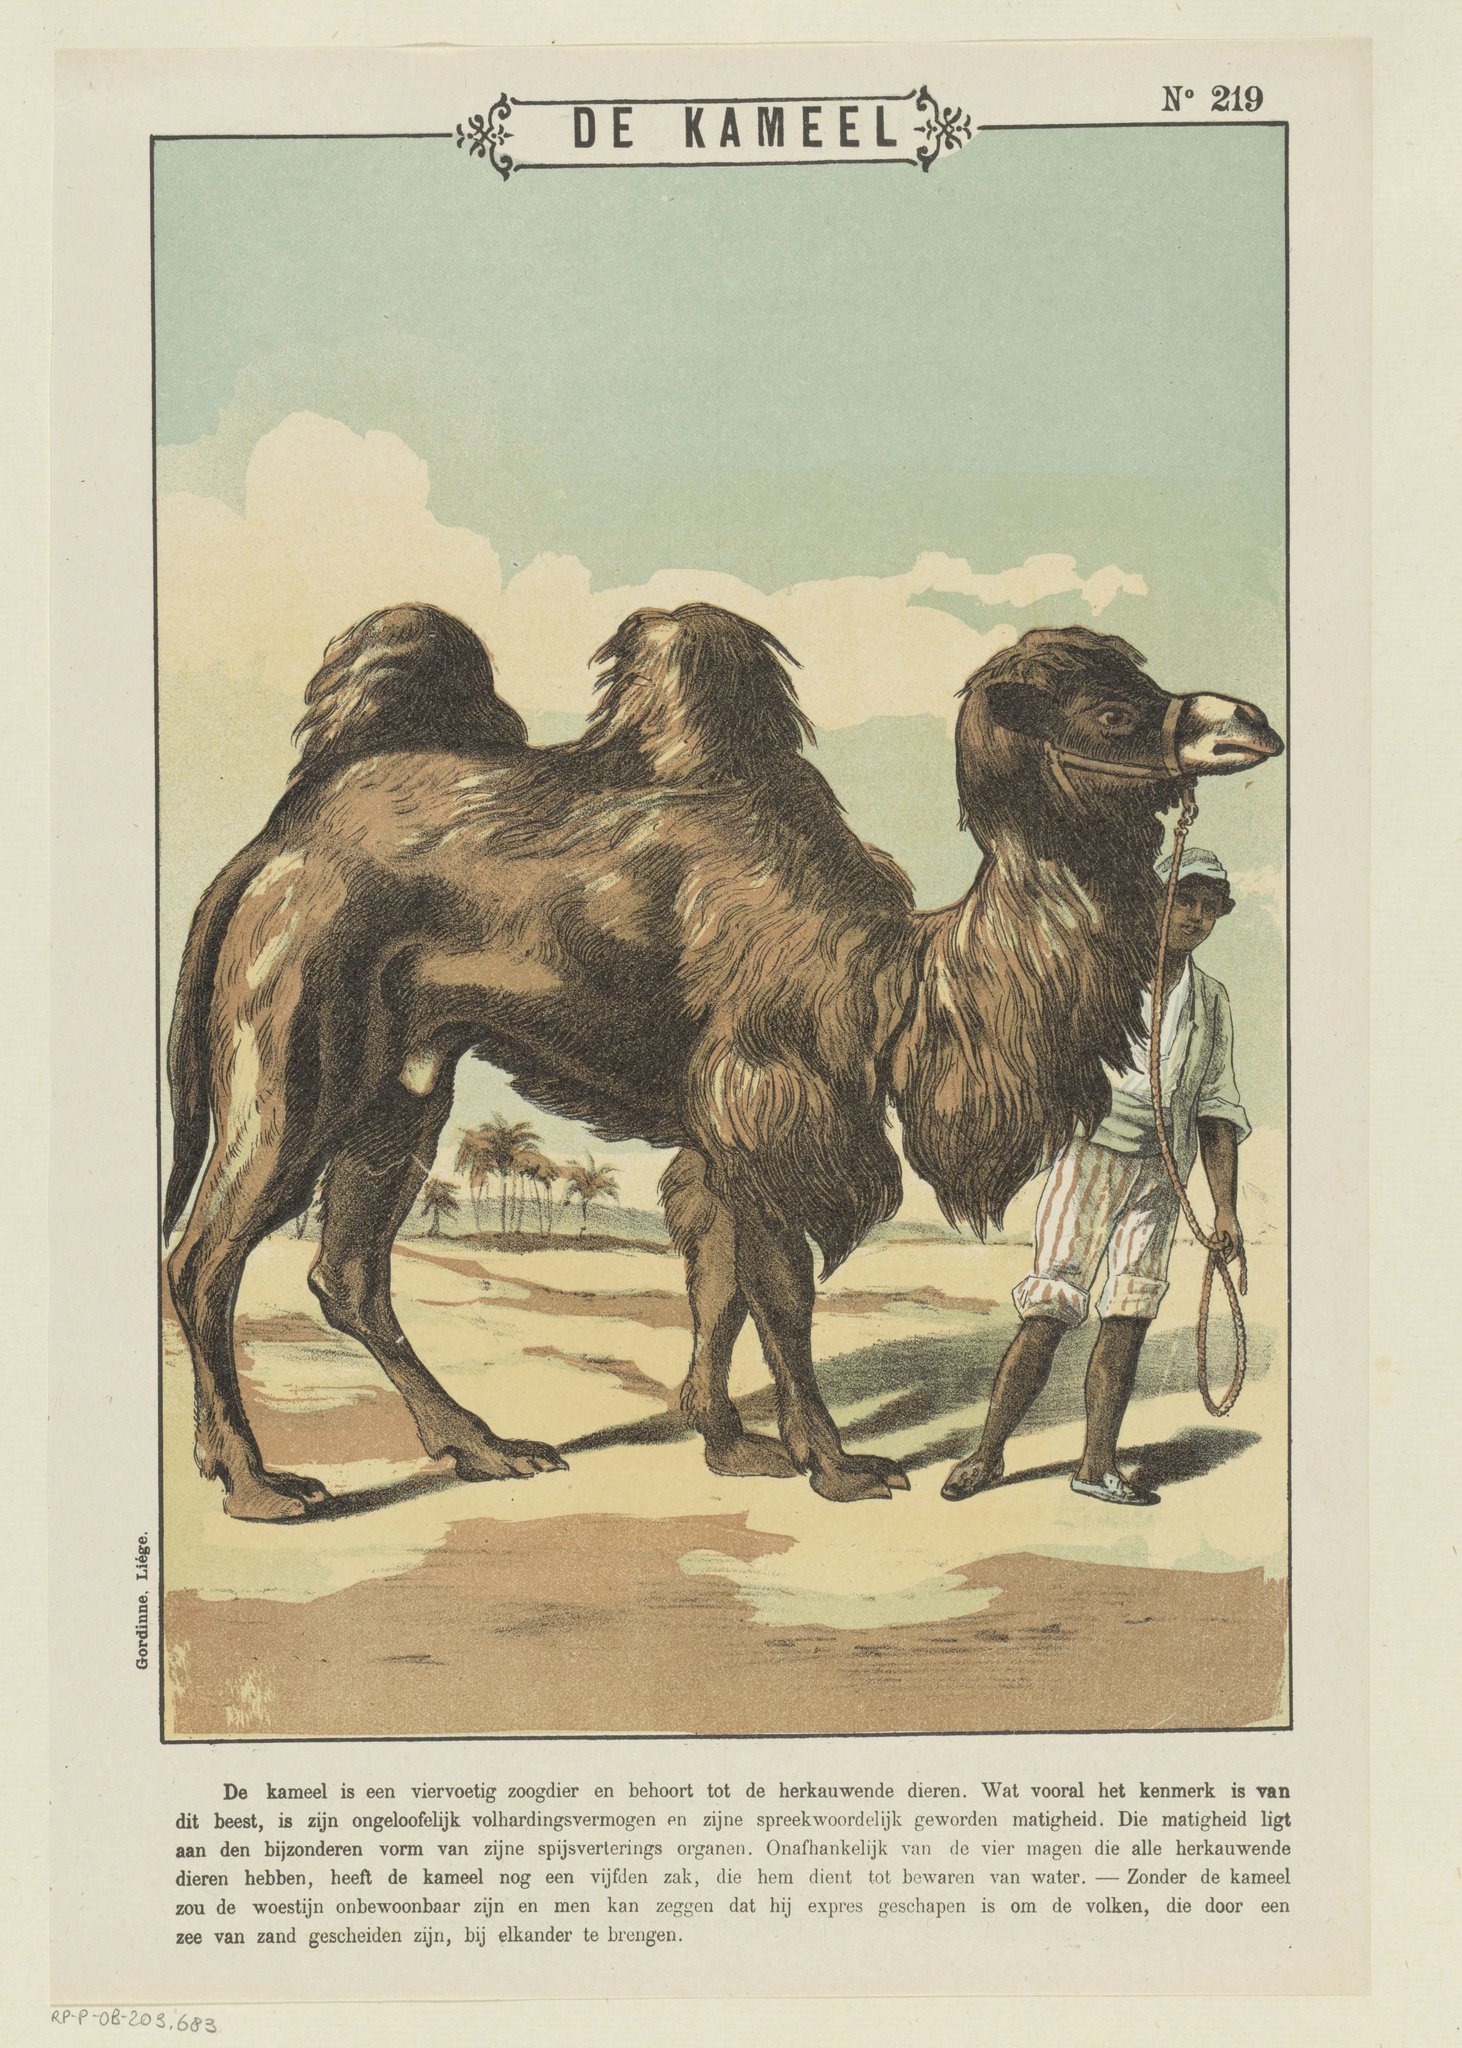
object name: popular print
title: De kameel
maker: Anonymous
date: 1894-1959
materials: paper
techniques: lithograph, letterpress printing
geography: liège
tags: pig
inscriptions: collector's mark: Lugt 2760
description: Blad met een grote voorstelling van een kameel. In de ondermarge een onderschrift. Genummerd rechtsboven: No 219.